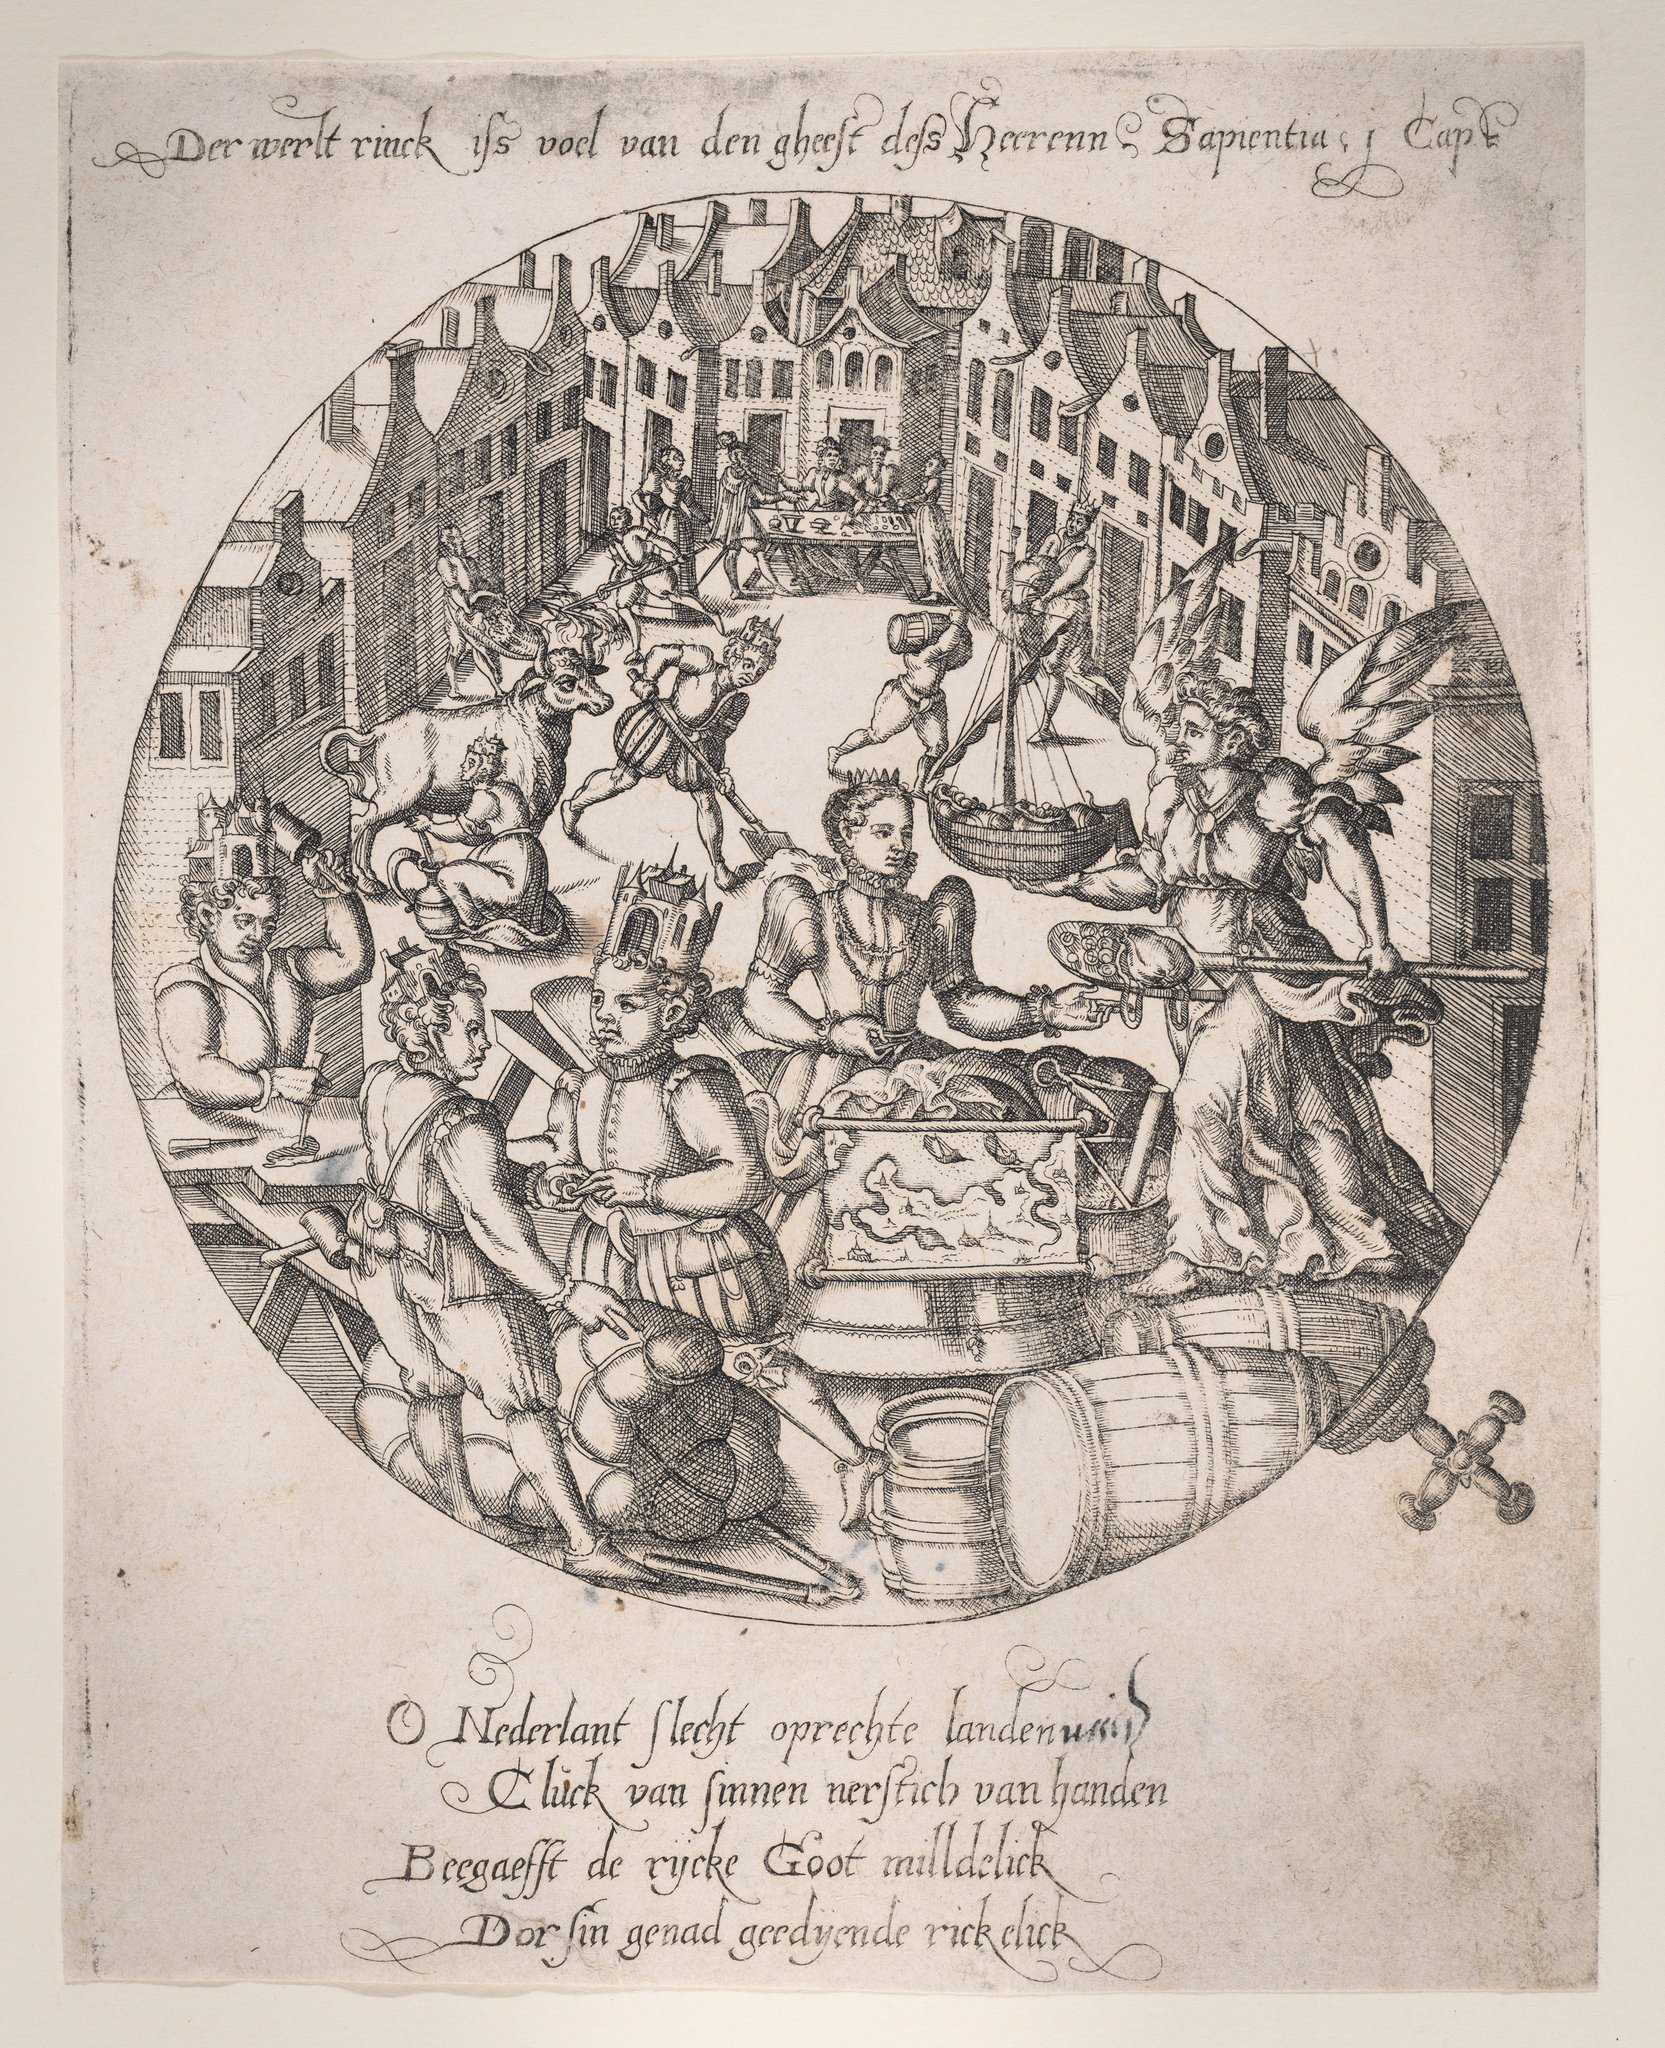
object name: print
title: The world is full of the spirit of the Lord (Wisdom of Solomon 1:7), plate 1 from a series of Four Allegories of the Netherlands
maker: anonymous, netherlandish, 16th century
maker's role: artist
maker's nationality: netherlandish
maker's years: 1500-1600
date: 1570-1572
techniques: etching